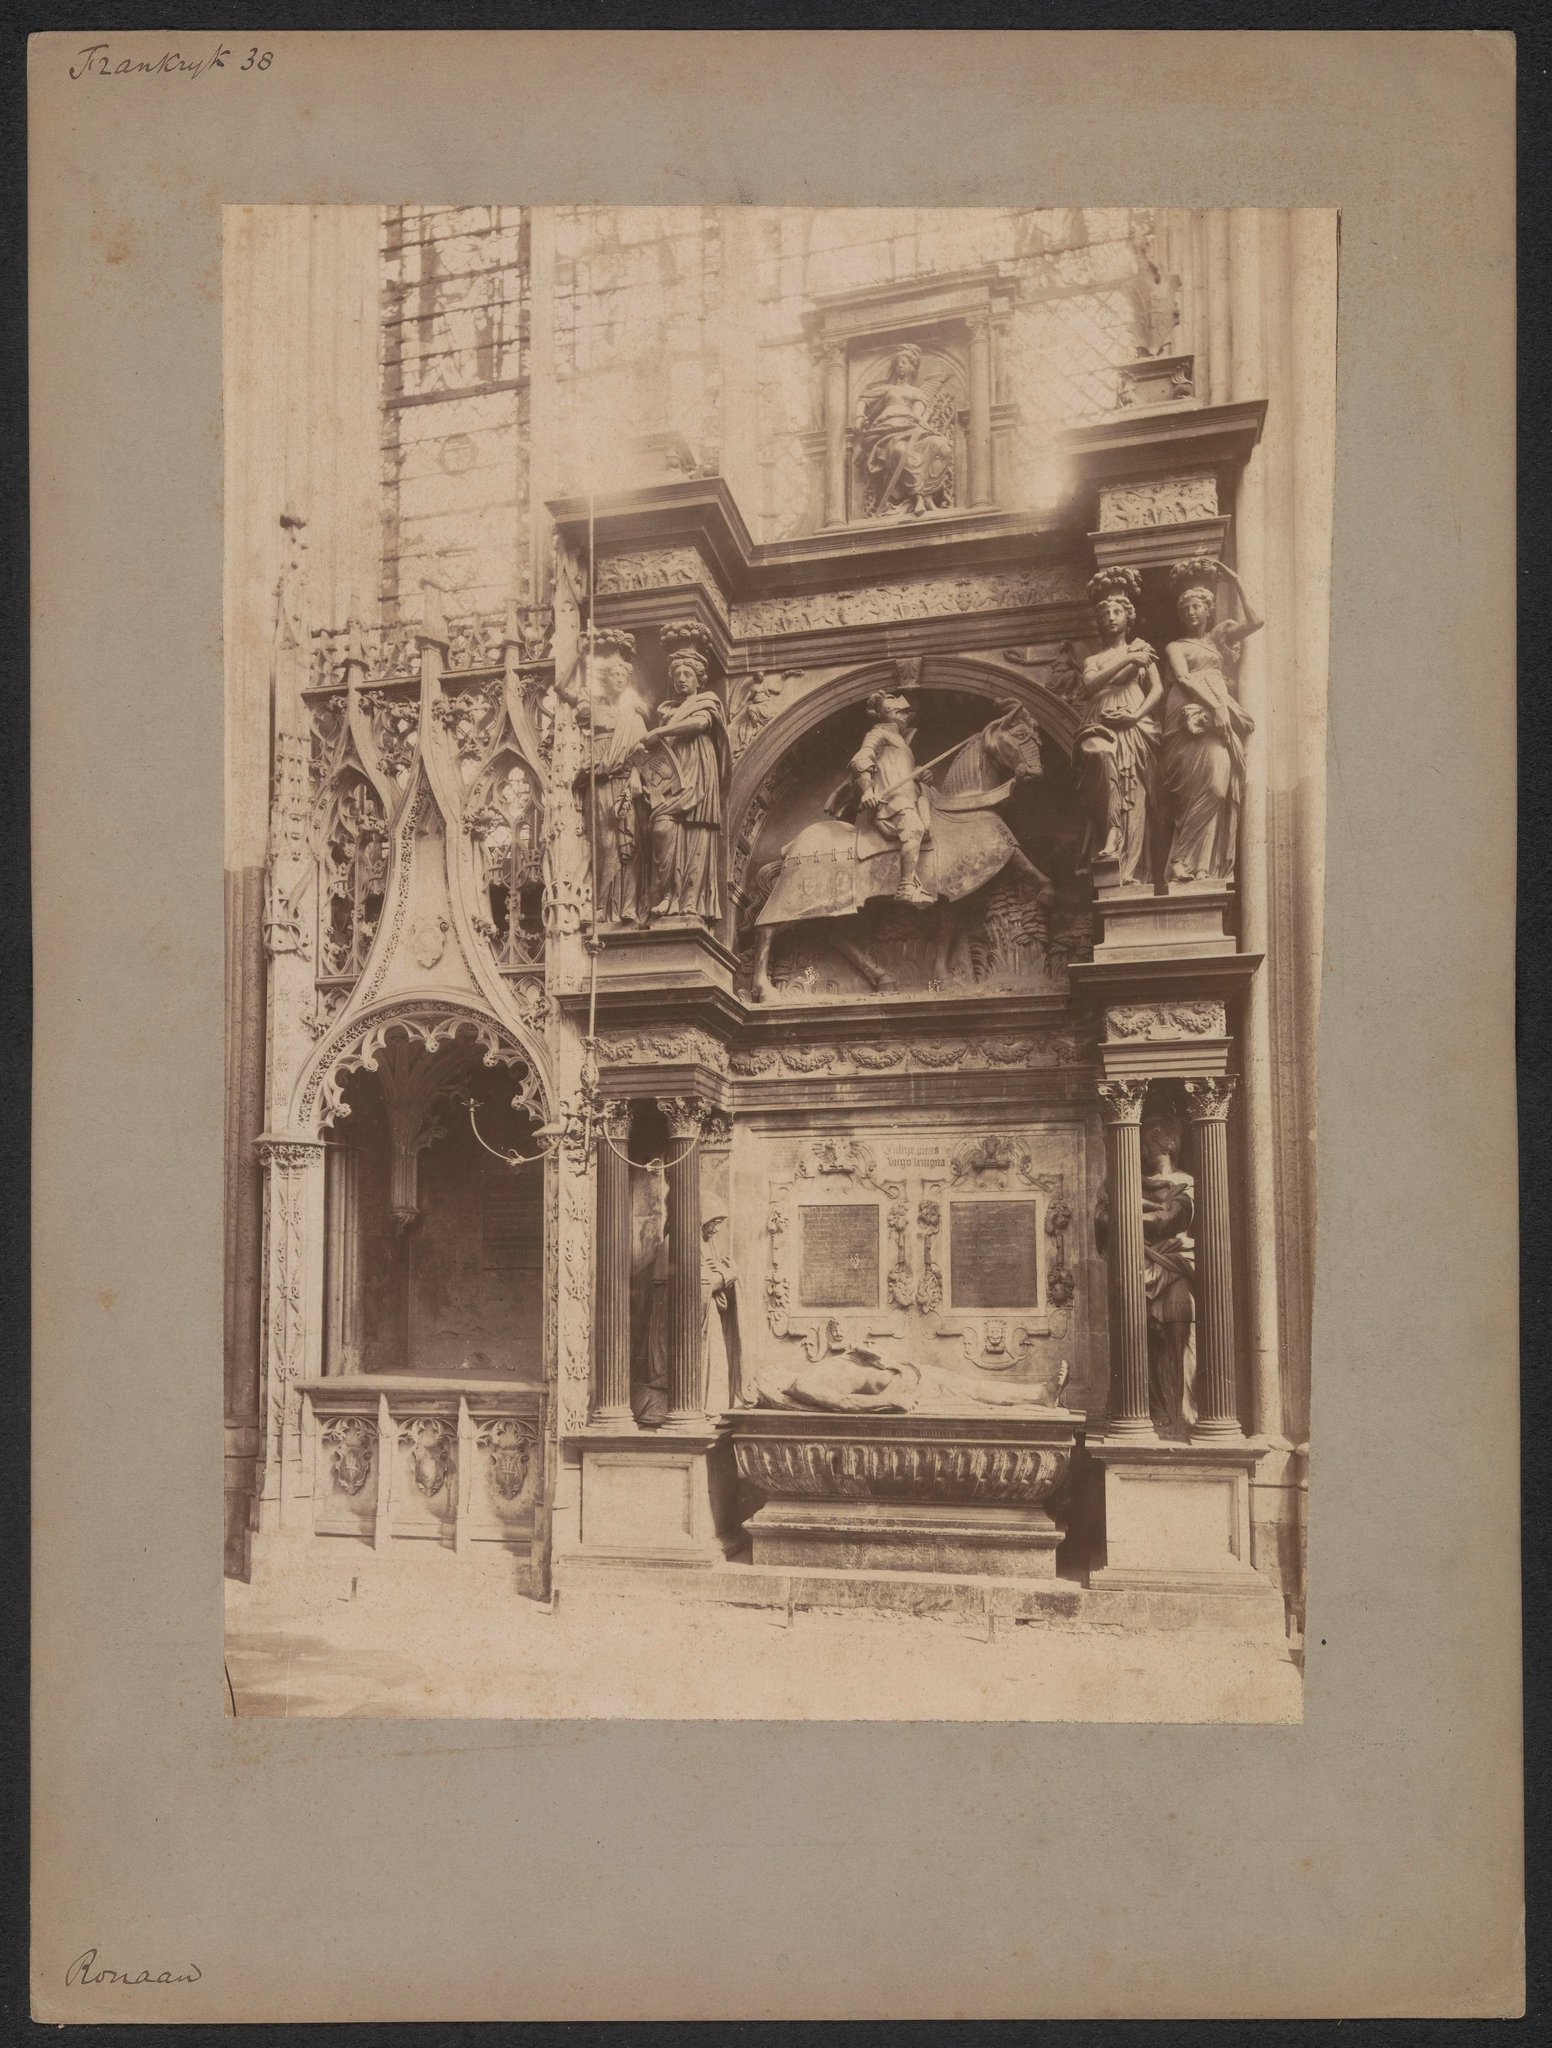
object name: photograph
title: Gezicht op de graftombe van Louis de Breze in de Notre-Dame kathedraal in Rouen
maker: Anonymous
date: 1850-1900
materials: cardboard, photographic support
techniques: albumen print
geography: rouen cathedral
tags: grave, tomb, interior of church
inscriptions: annotation: ‘Rouaan’, collector's mark: ‘RIJKS NORMAALSCHOOL voor T[EEKENONDERWIJZERS] AMSTERDA[M]’, annotation: ‘Rouen’, annotation: ‘Frankrijk 38’